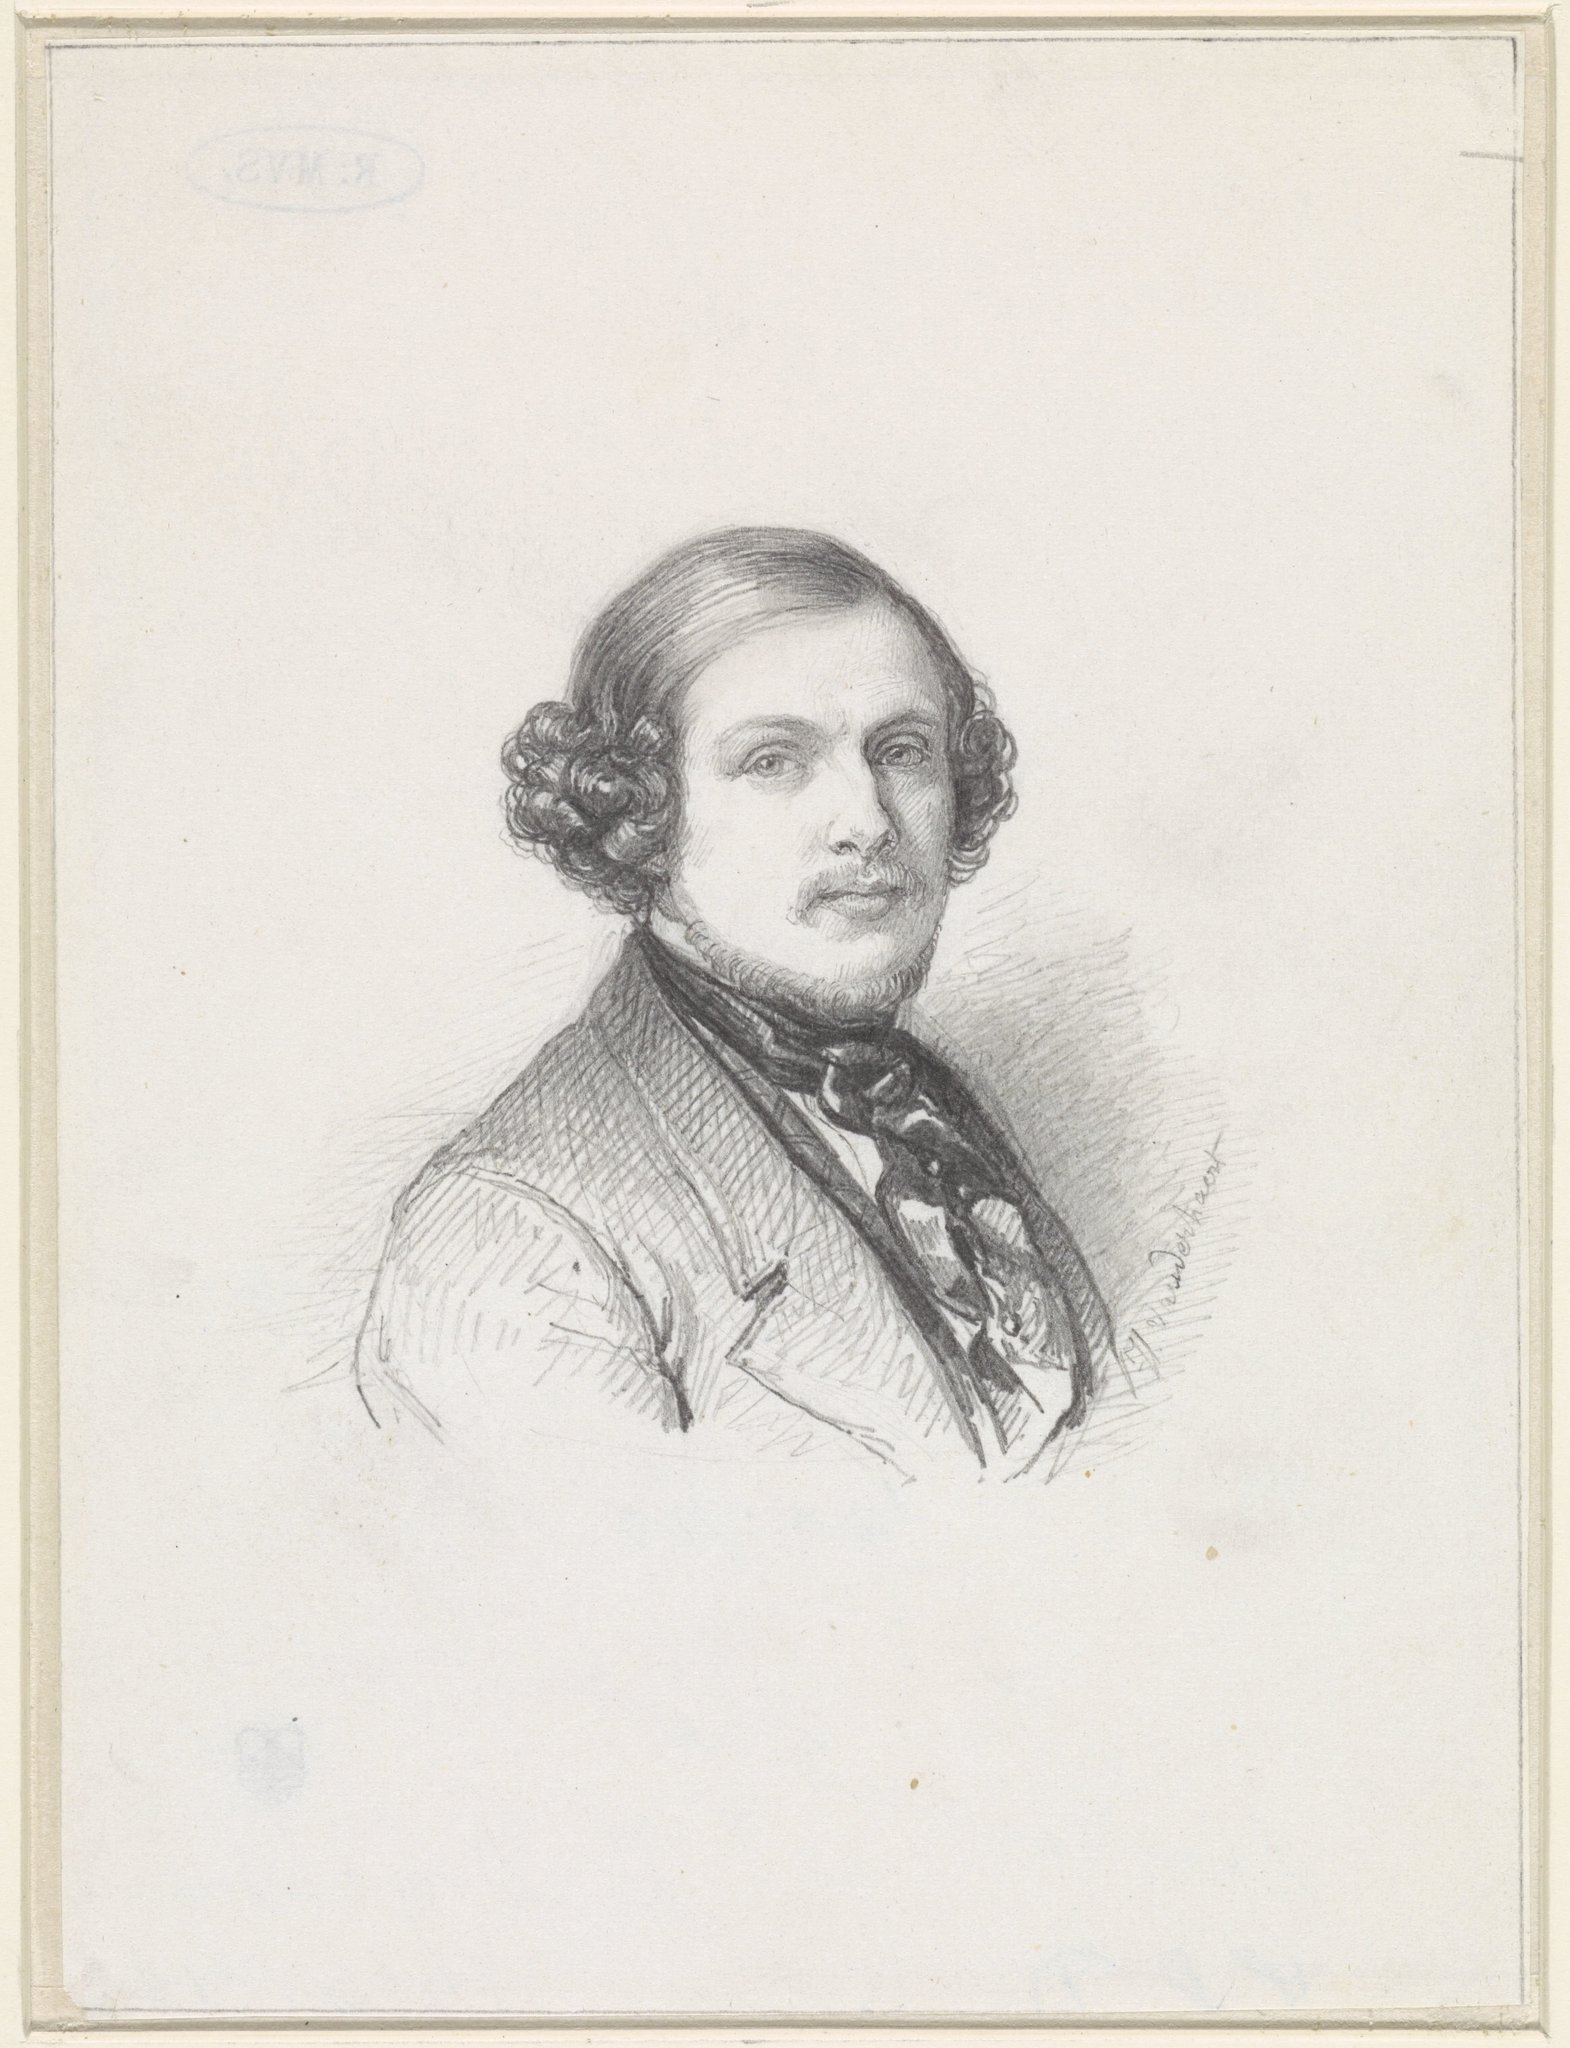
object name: drawing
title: Portret van Josephus Laurentius Dijckmans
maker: henri van der haert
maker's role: draughtsman, print maker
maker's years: 1790-1846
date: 1841-1842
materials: paper, pencil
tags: lierre, antwerp, painter, joseph-laurens dijckmans, historical persons, portrait, self-portrait of painter, portrait, self-portrait of artist, portrait, self-portrait of draughtsman